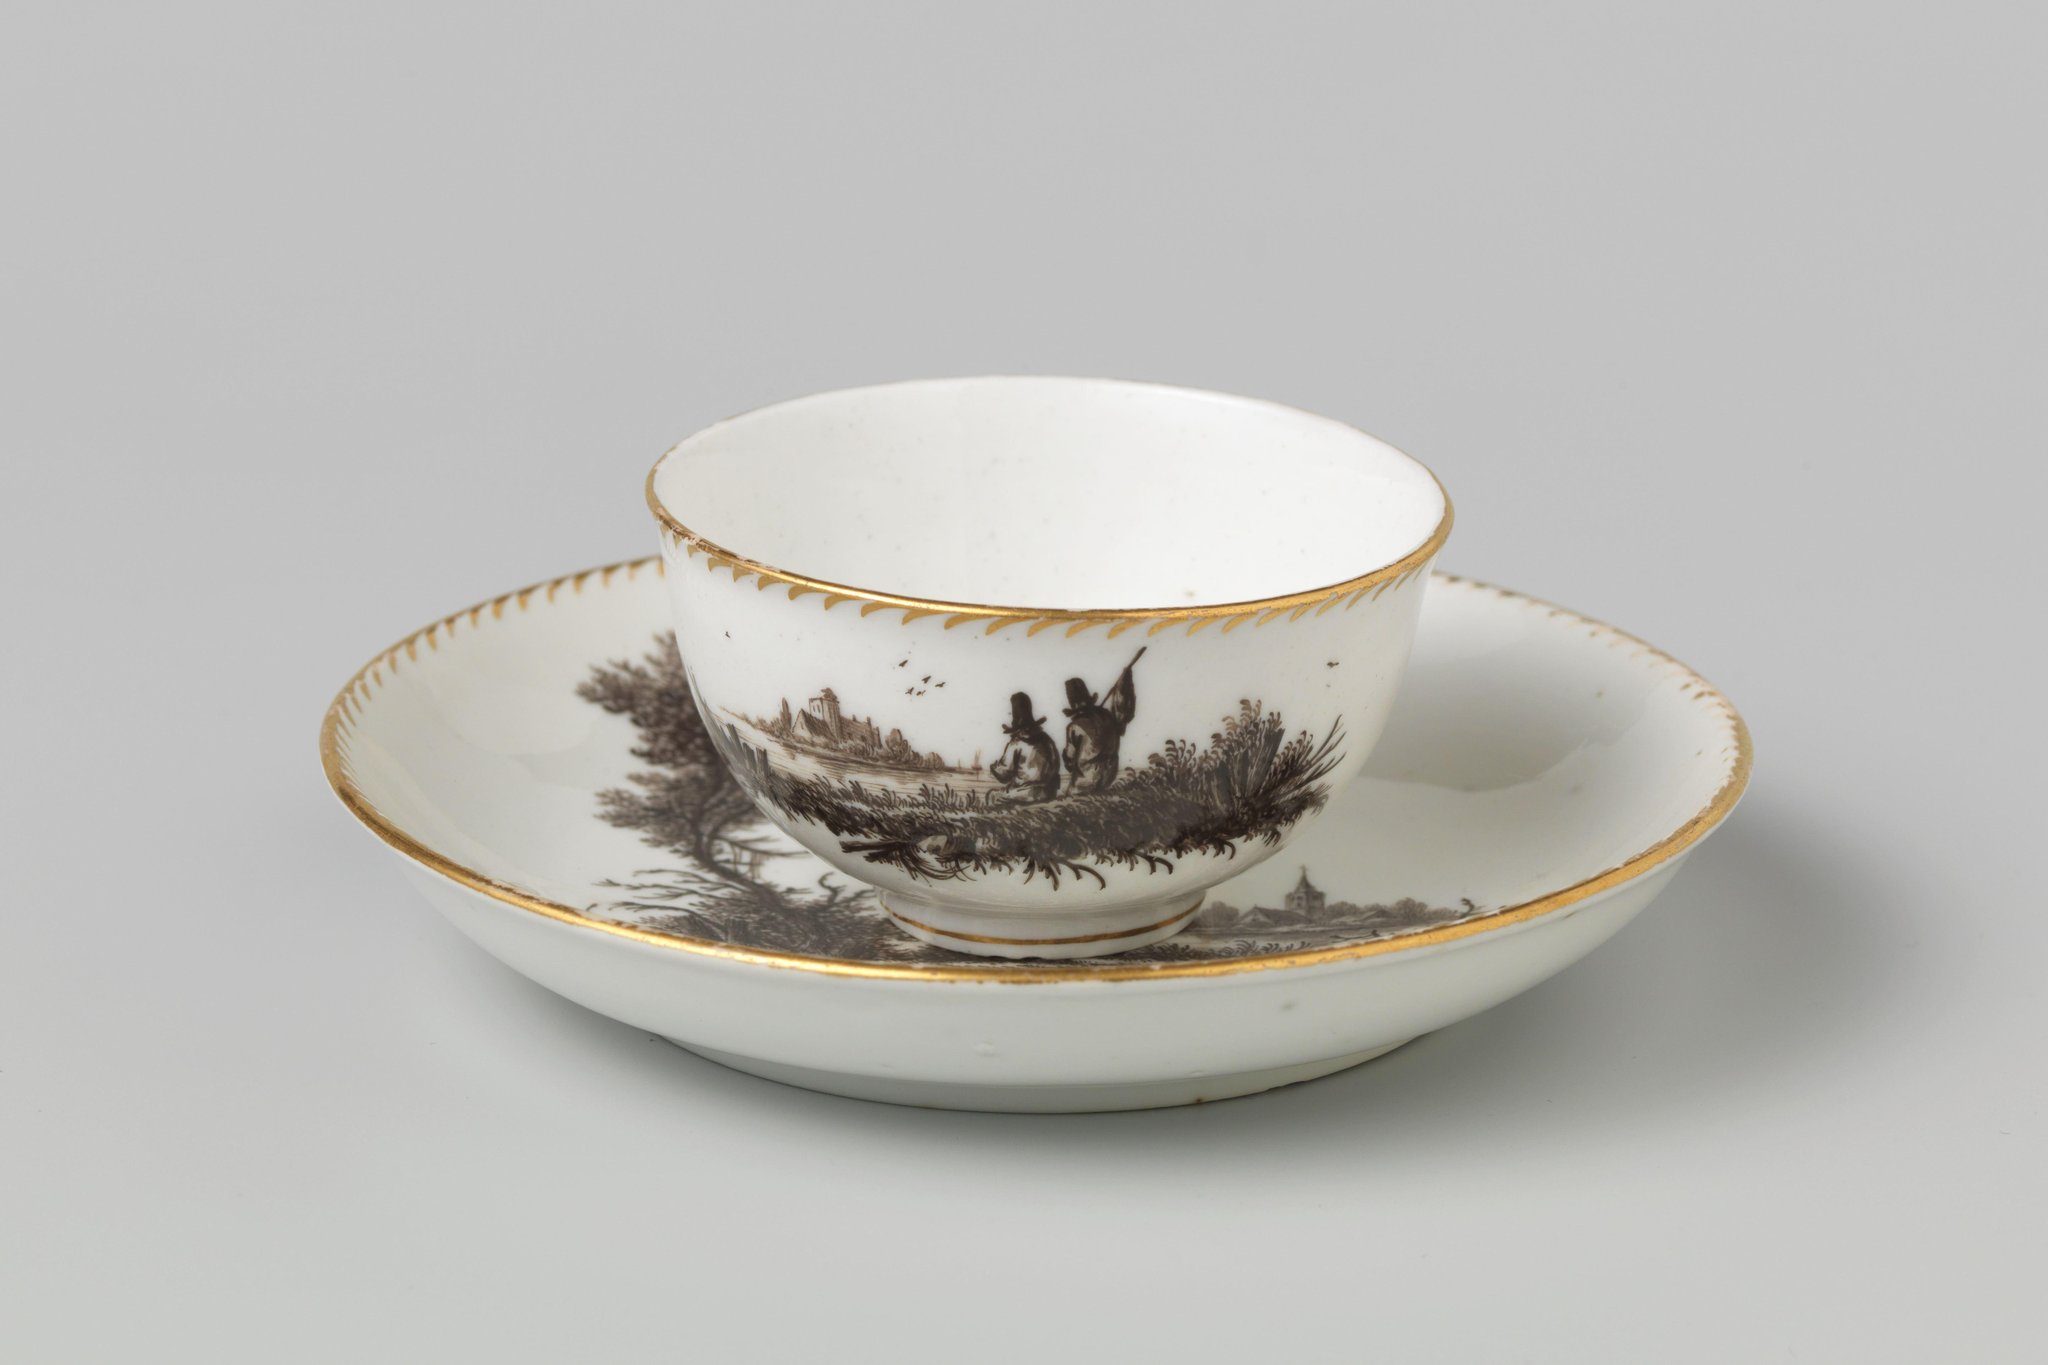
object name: kop en schotel, kop en schotel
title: Kop en schotel met riviergezicht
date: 1774-1784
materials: porcelain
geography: loosdrecht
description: Parts of a tea service. Porcelain, painted in encre de Chine. Loosdrecht, c. 1778-1780. Factory of Joannes de Mol.